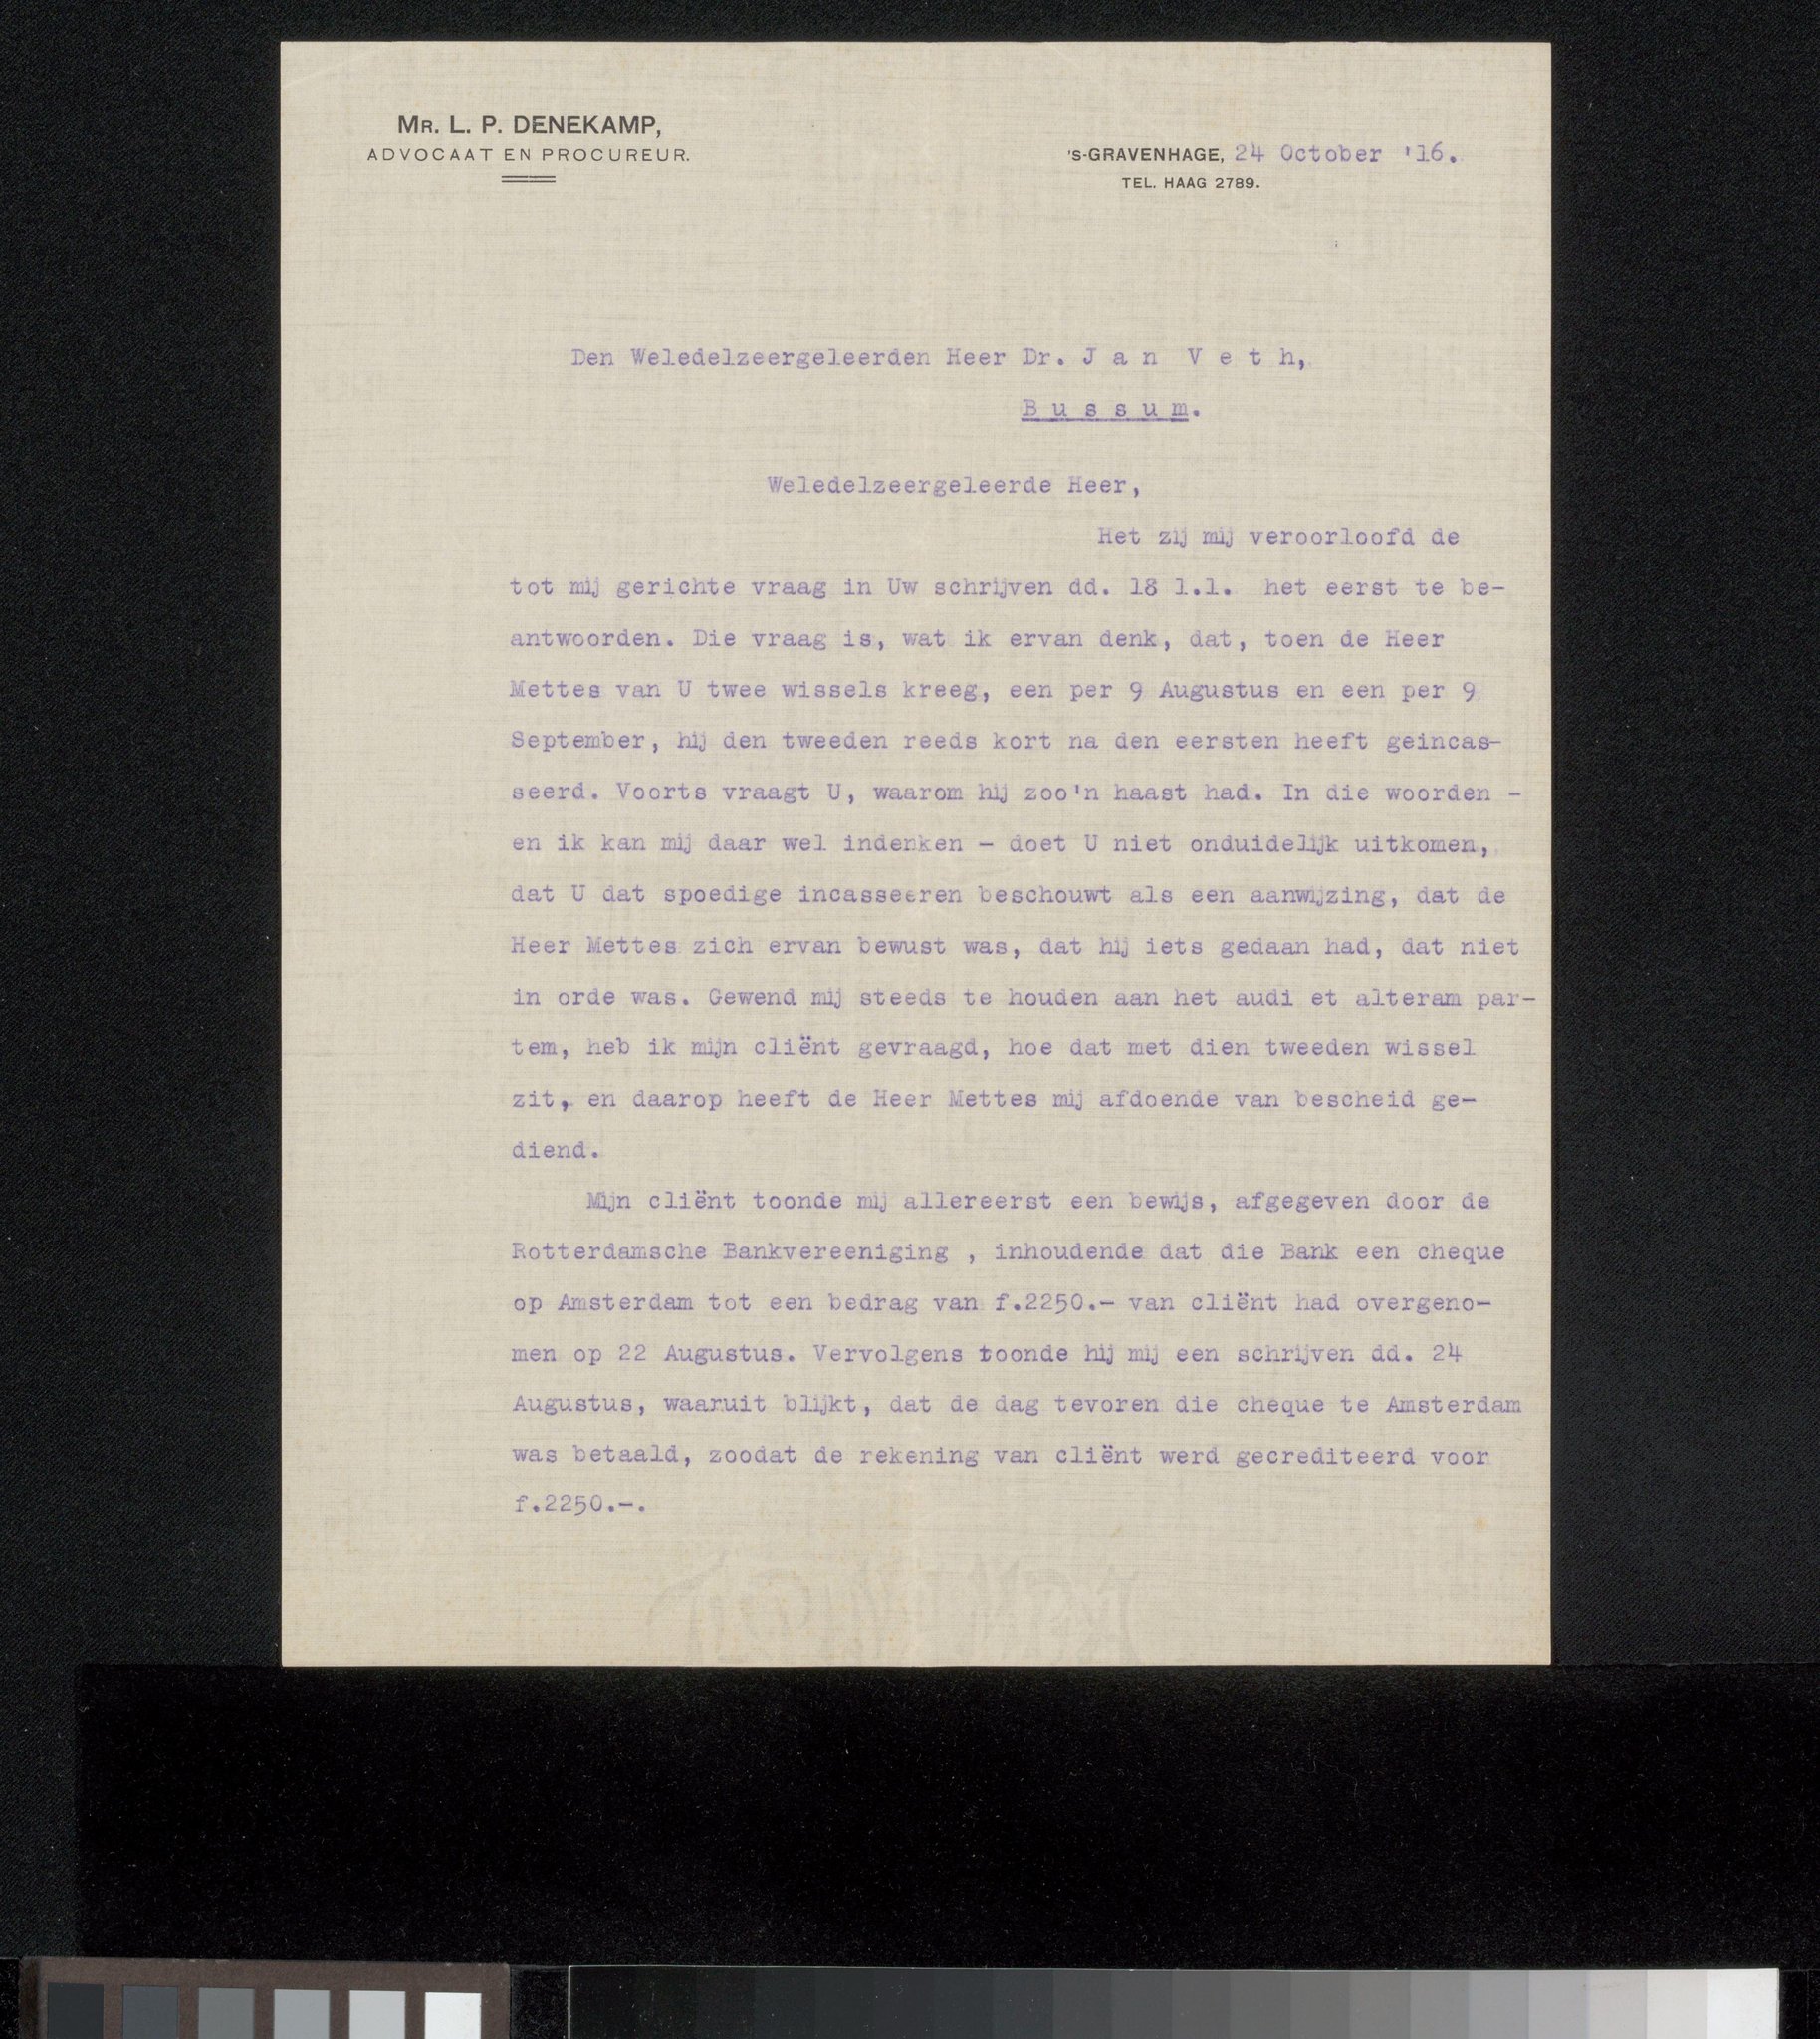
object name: letter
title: Brief aan Jan Veth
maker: l.p. denekamp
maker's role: advocaat, procureur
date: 1916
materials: ink, paper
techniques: pen, printing, typewriting, writing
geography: the hague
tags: dordrecht, painter, print maker, draughtsman, designer, jan veth, leiden, rembrandt van rijn, hoorn (north holland), the hague, the graphic arts, art collecting, money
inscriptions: watermark, collector's mark: ‘RPK’